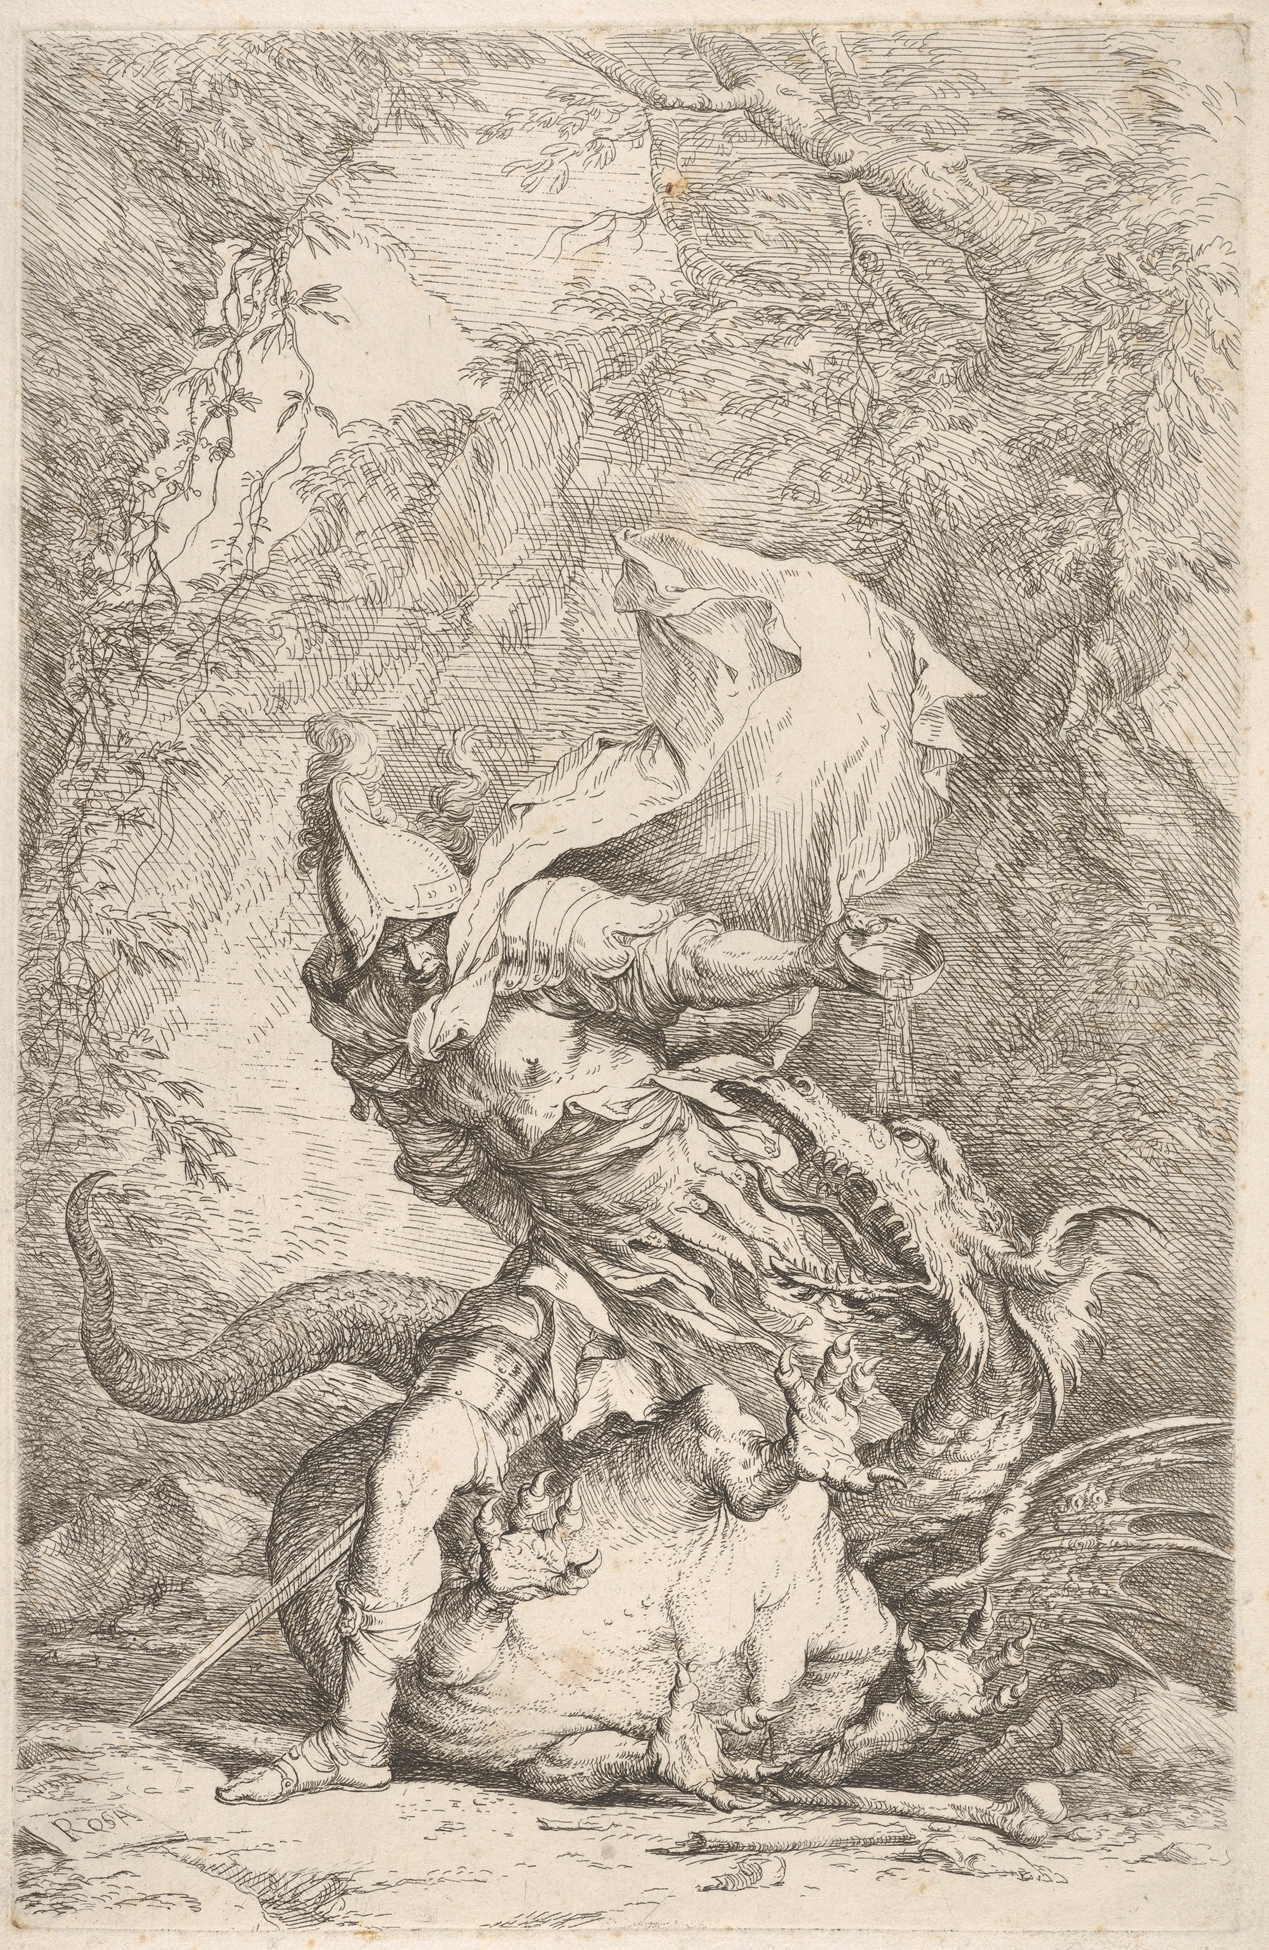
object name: print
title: Jason and the Dragon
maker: salvator rosa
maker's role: artist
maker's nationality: italian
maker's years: 1615-1673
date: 1663-1664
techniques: drypoint, etching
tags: jason,dragons